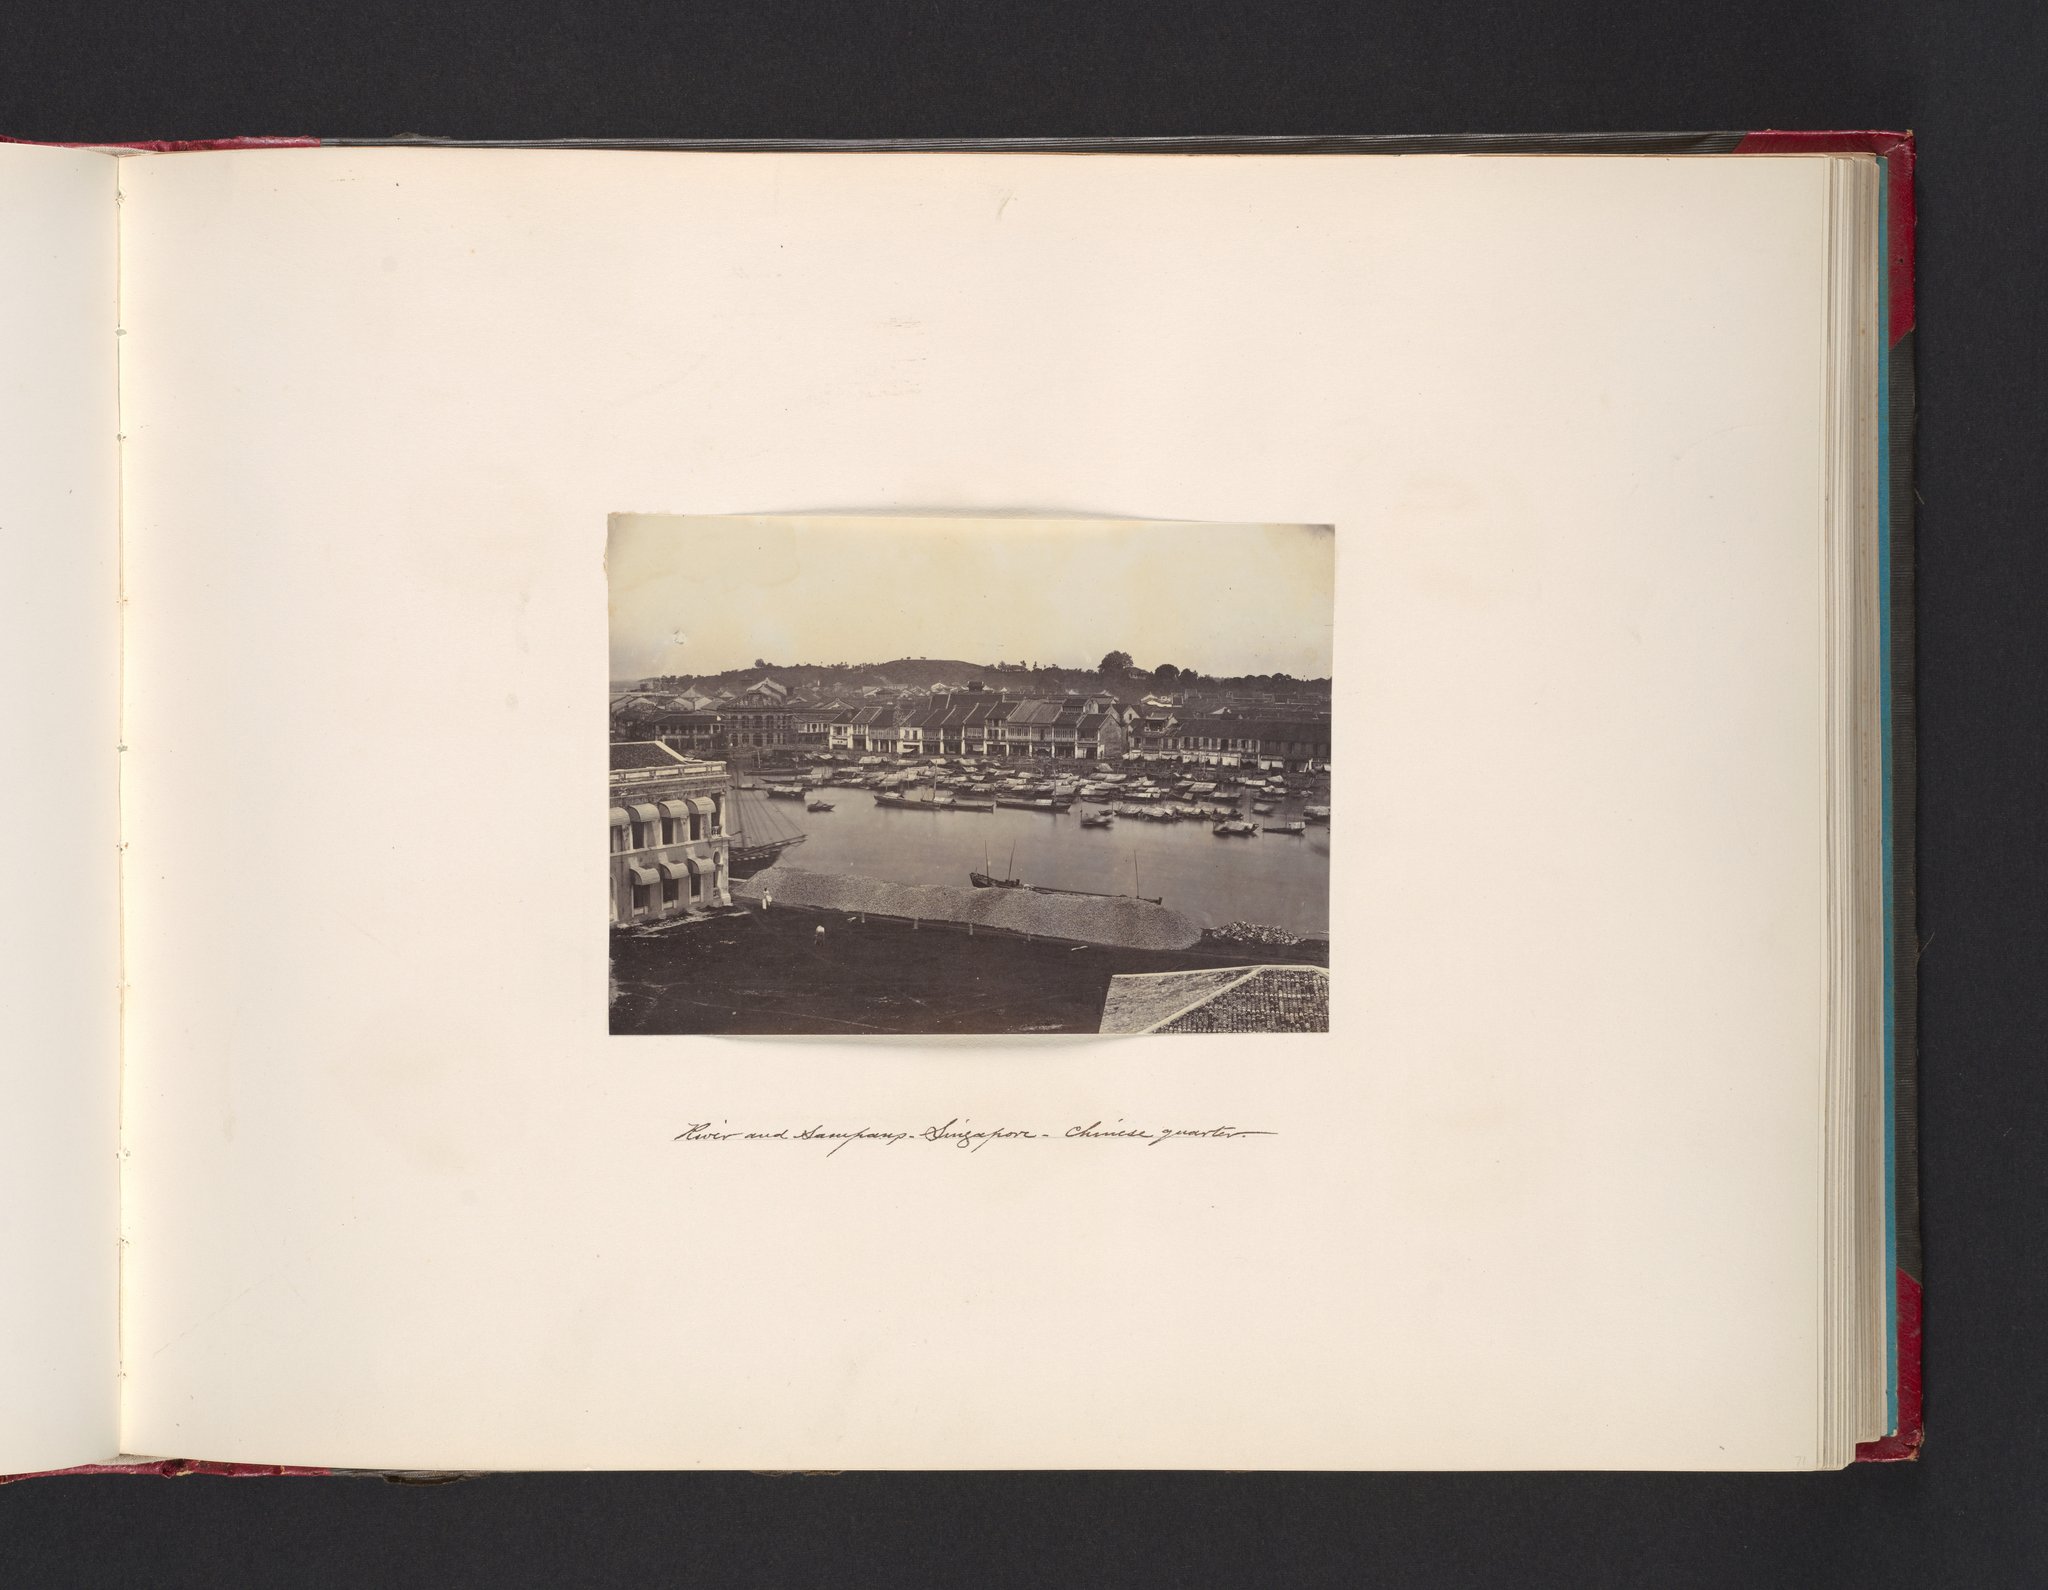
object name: photograph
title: River and Sanpans. Singapore. Chinese Quarter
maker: john thomson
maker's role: artist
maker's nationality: british, scottish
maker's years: 1837-1921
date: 1865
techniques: albumen silver print, glass negative